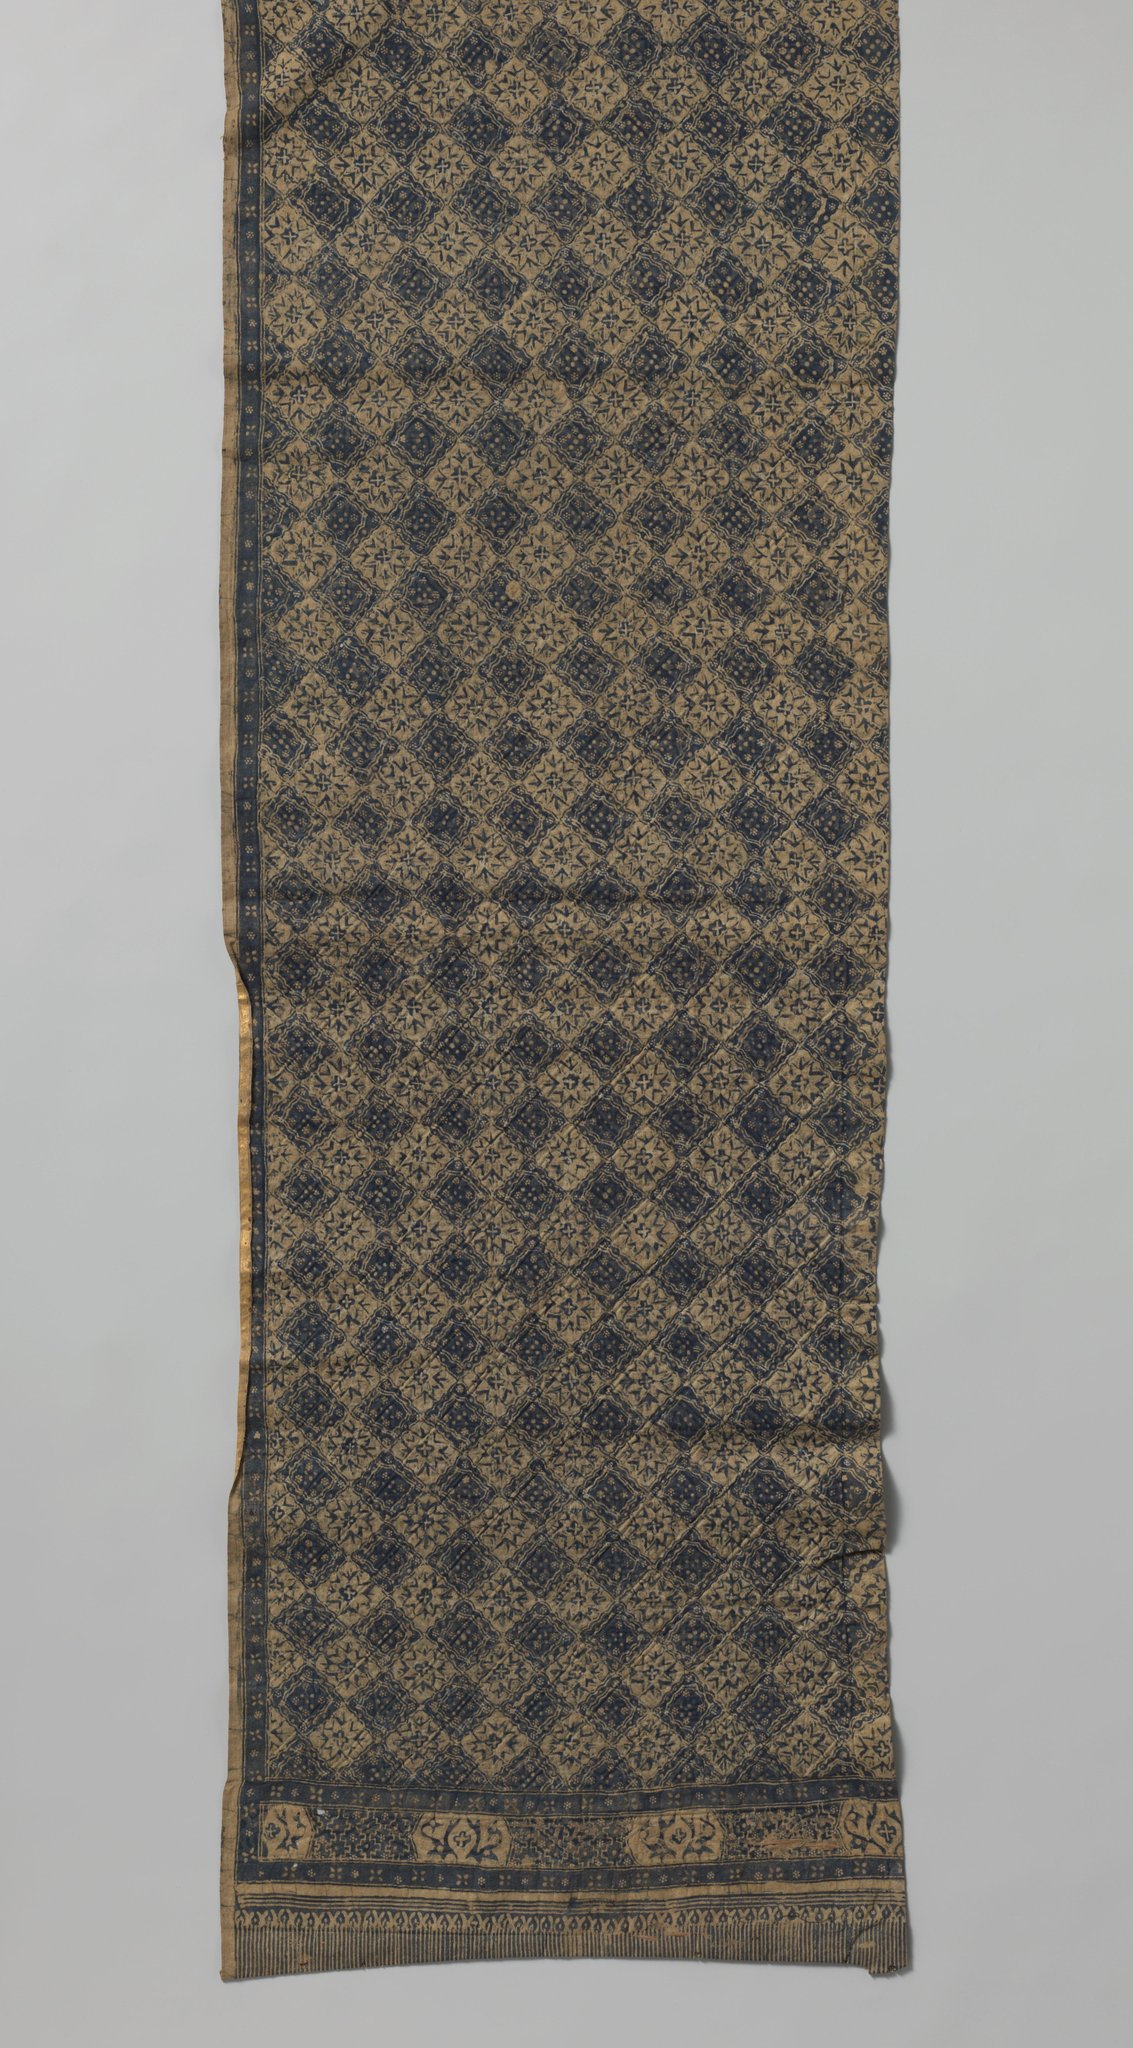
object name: heupdoek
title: Heupband van oosterse textiel; batik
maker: Anonymous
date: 1400-1950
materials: cotton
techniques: printing, weave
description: Heupband van oosterse textiel. De band bestaat uit een bedrukte katoen. Het patroon bestaat uit blauwe en witte ruiten. De blauwe ruiten zijde gevuld met lijnen en stippen, de witte met een krruis waar omheen zigzag lijnen. Op de achterzijde is goudpoeder aangebracht in een ander motief.